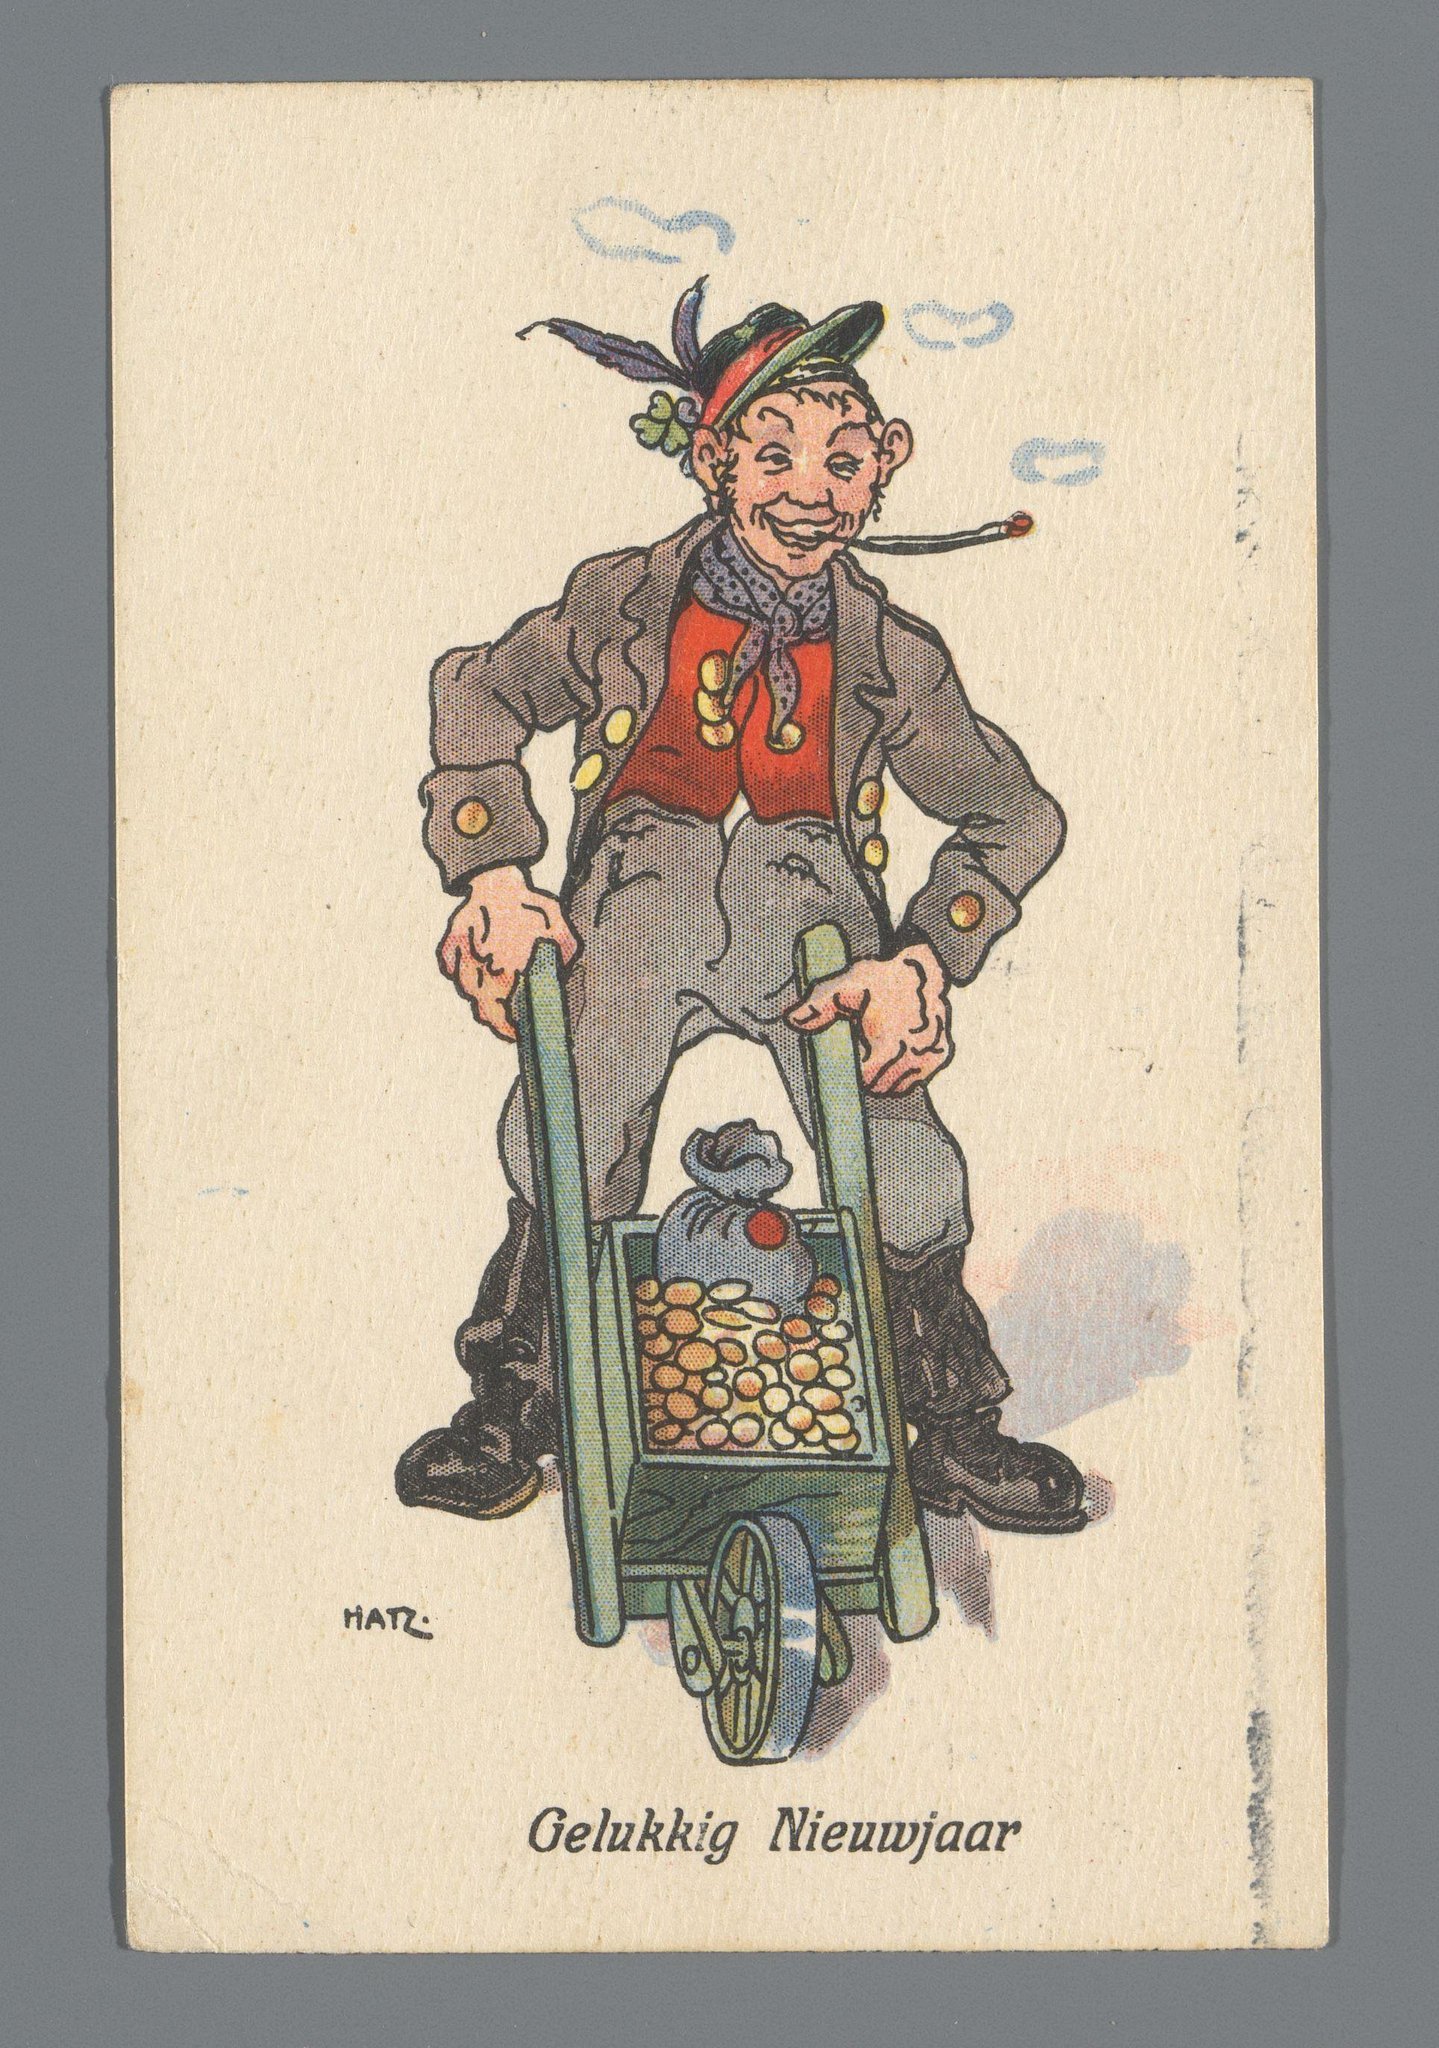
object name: print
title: Nieuwjaarswens voor 1920 van Chris en Bep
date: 1919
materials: paper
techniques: lithograph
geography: vienna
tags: purse, money-bag, wheelbarrow, coin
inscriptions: : ‘Haarlem 31.XII.19.5-6N’, postage stamp: ‘Nederland 1 1/2 cent’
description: Achter de naam van de uitgever (B.K.W.I. op het verso) staat nog het nummer 3040-3 vermeld. Dit is een kaartnummer en serienummer van de uitgever. Voor de bepaling van de rechten van dit object is gebruikt gemaakt van de vervaardigingsdatum van het object aangezien de relevante data voor de tekenaar onbekend zijn.